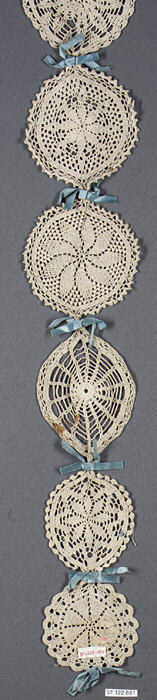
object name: sampler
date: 1801-1900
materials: cotton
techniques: crochet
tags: flowers